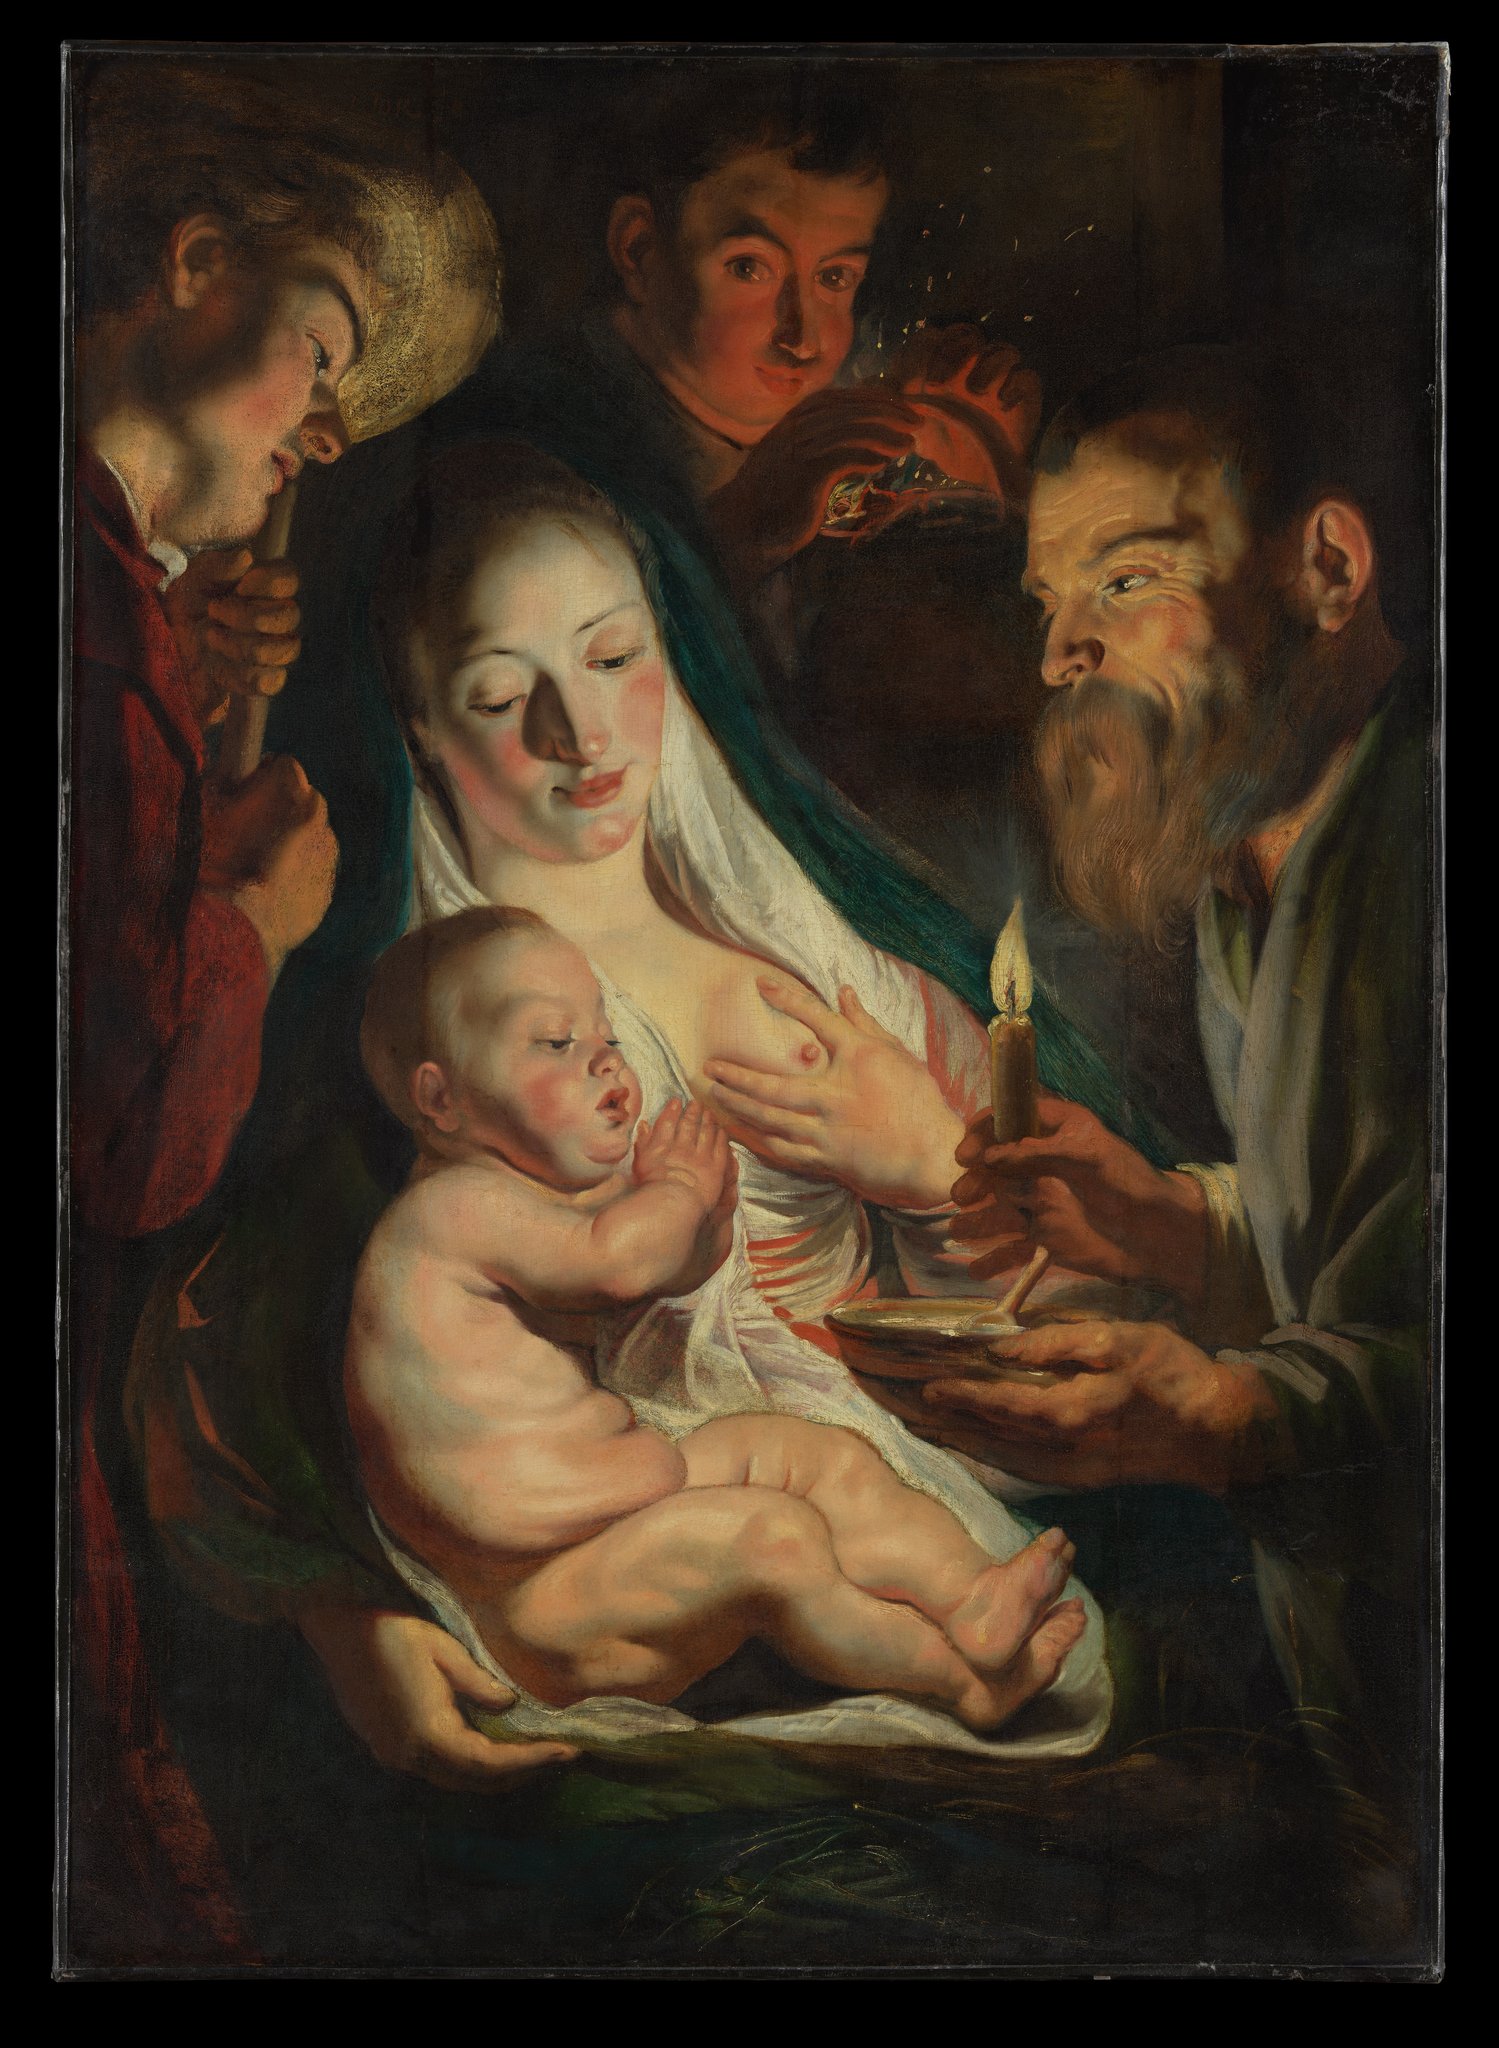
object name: painting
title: The Holy Family with Shepherds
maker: jacob jordaens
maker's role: artist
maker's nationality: flemish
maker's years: 1593-1678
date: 1616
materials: canvas, oil, wood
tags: christ,holy family,saint joseph,virgin mary,shepherds